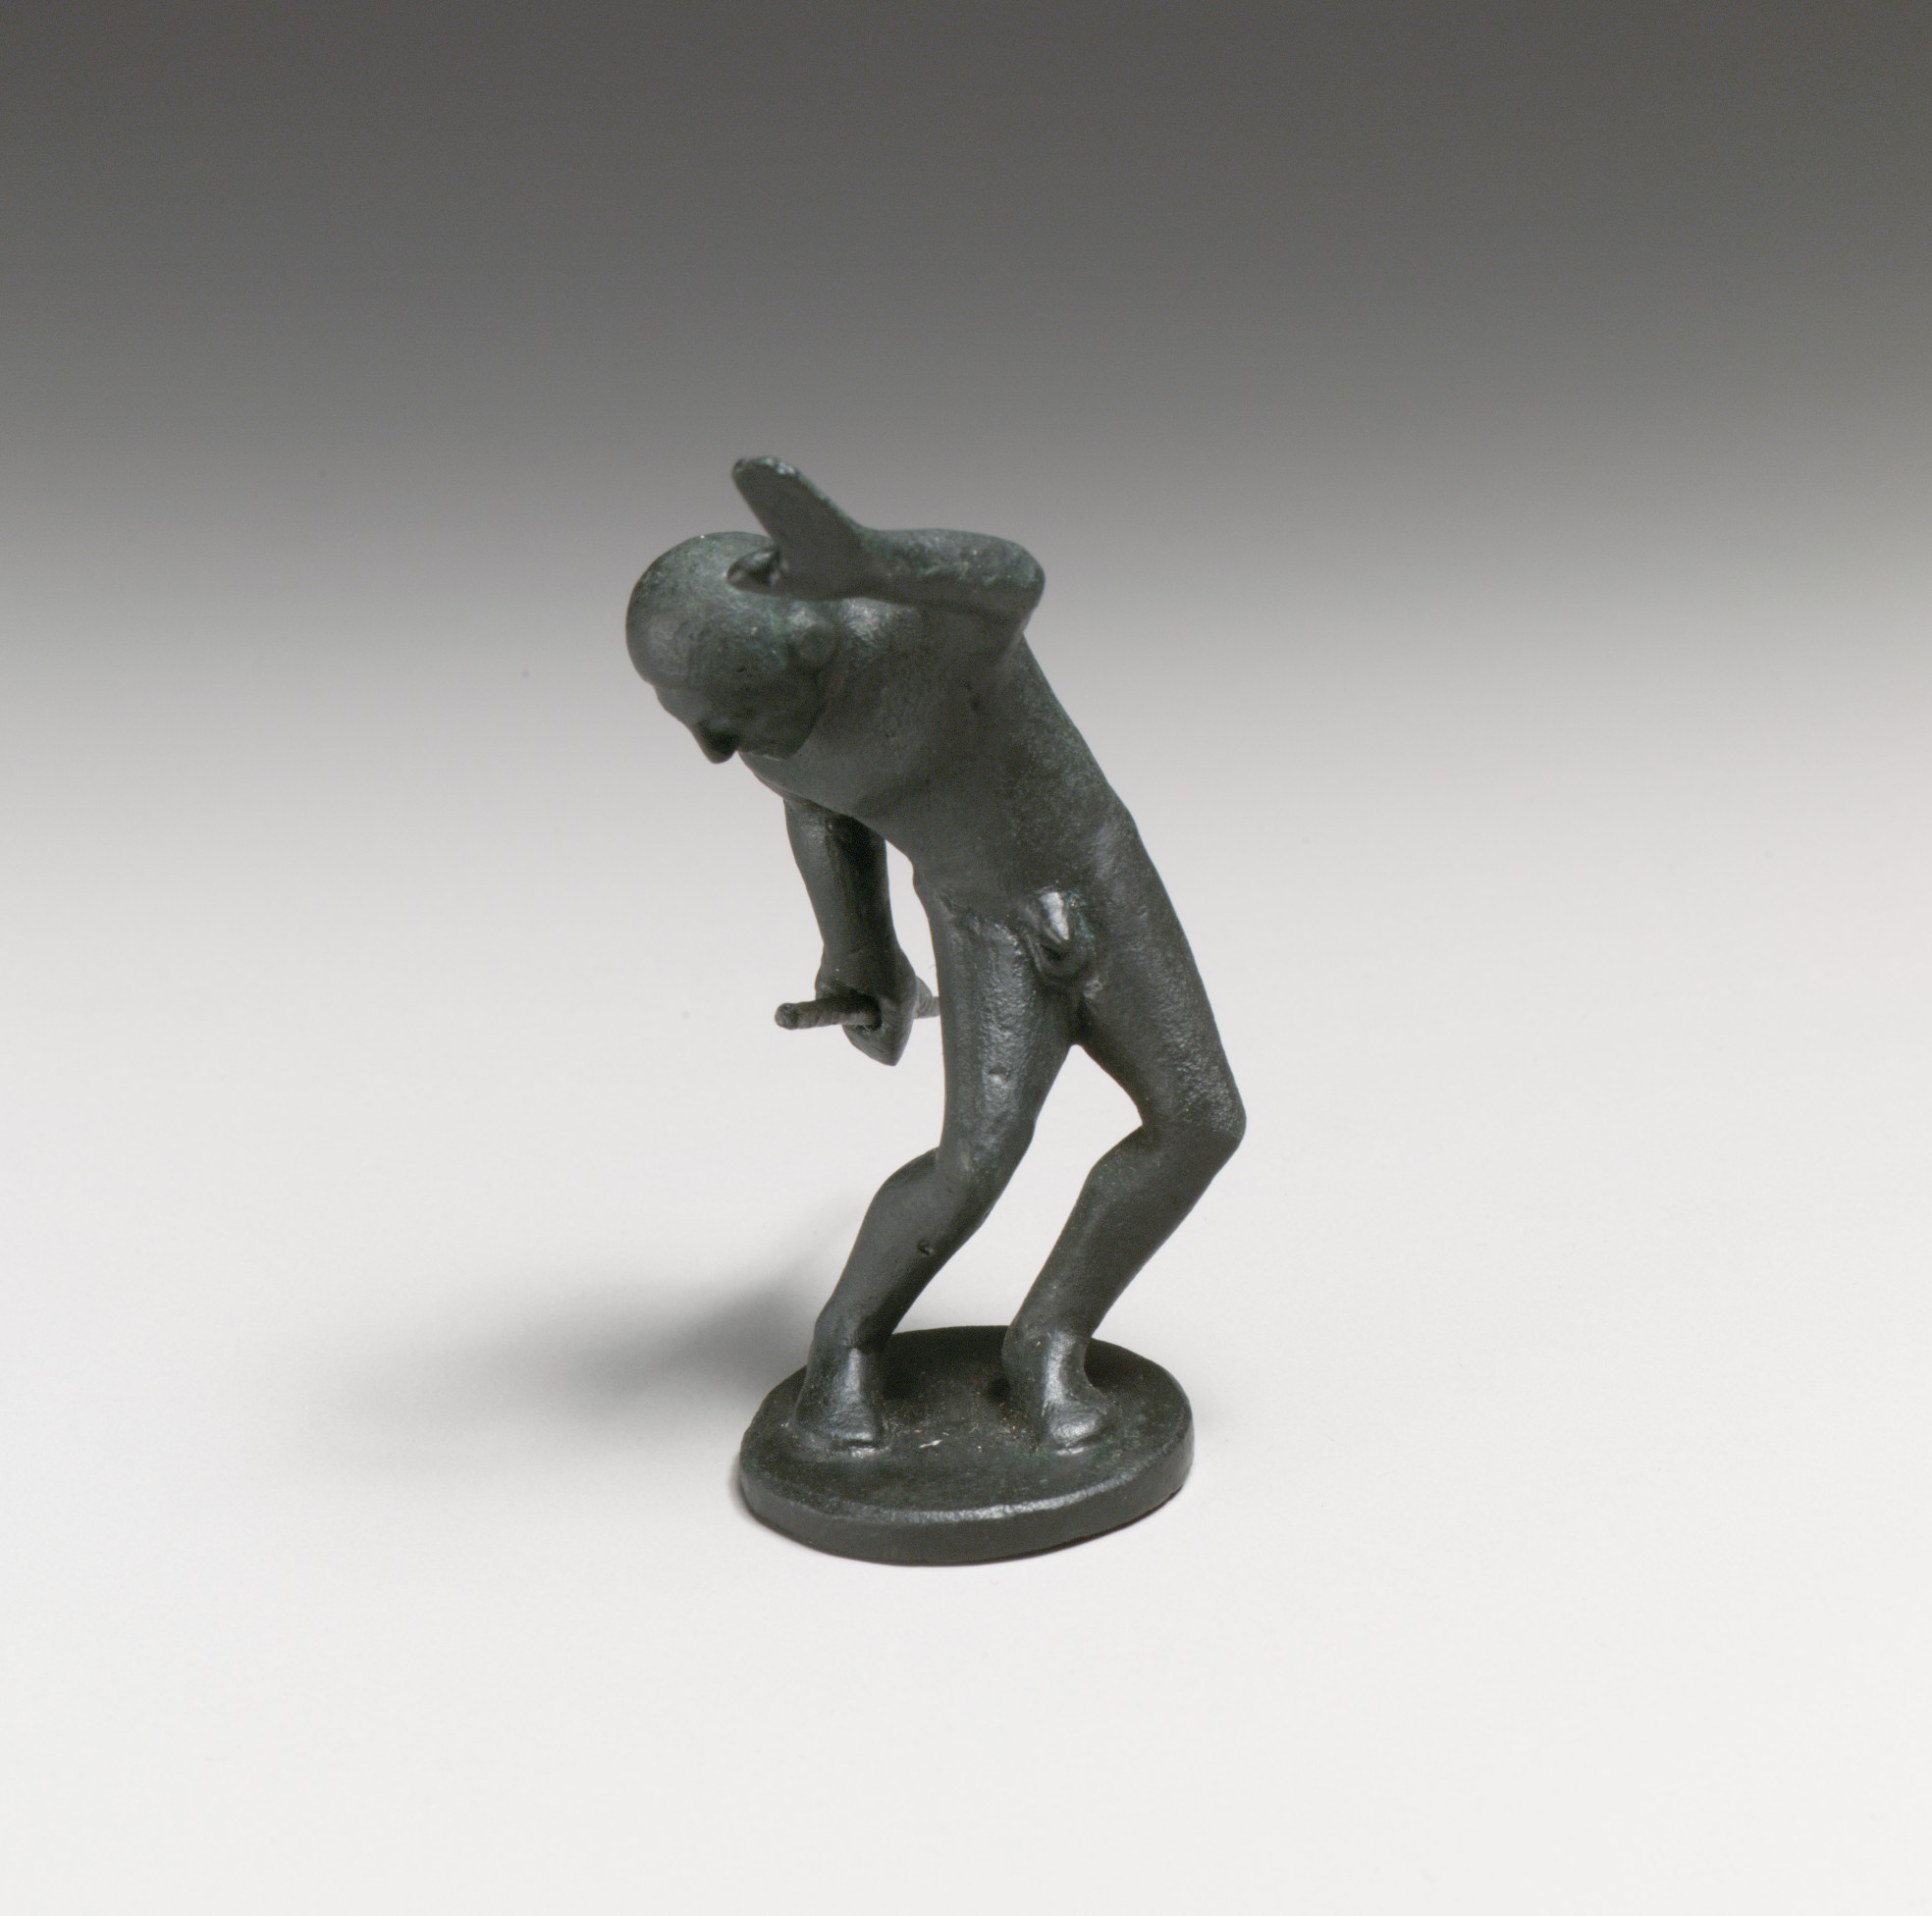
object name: statuette of an athlete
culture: etruscan or greek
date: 500-401 BCE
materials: bronze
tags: male nudes,athletes